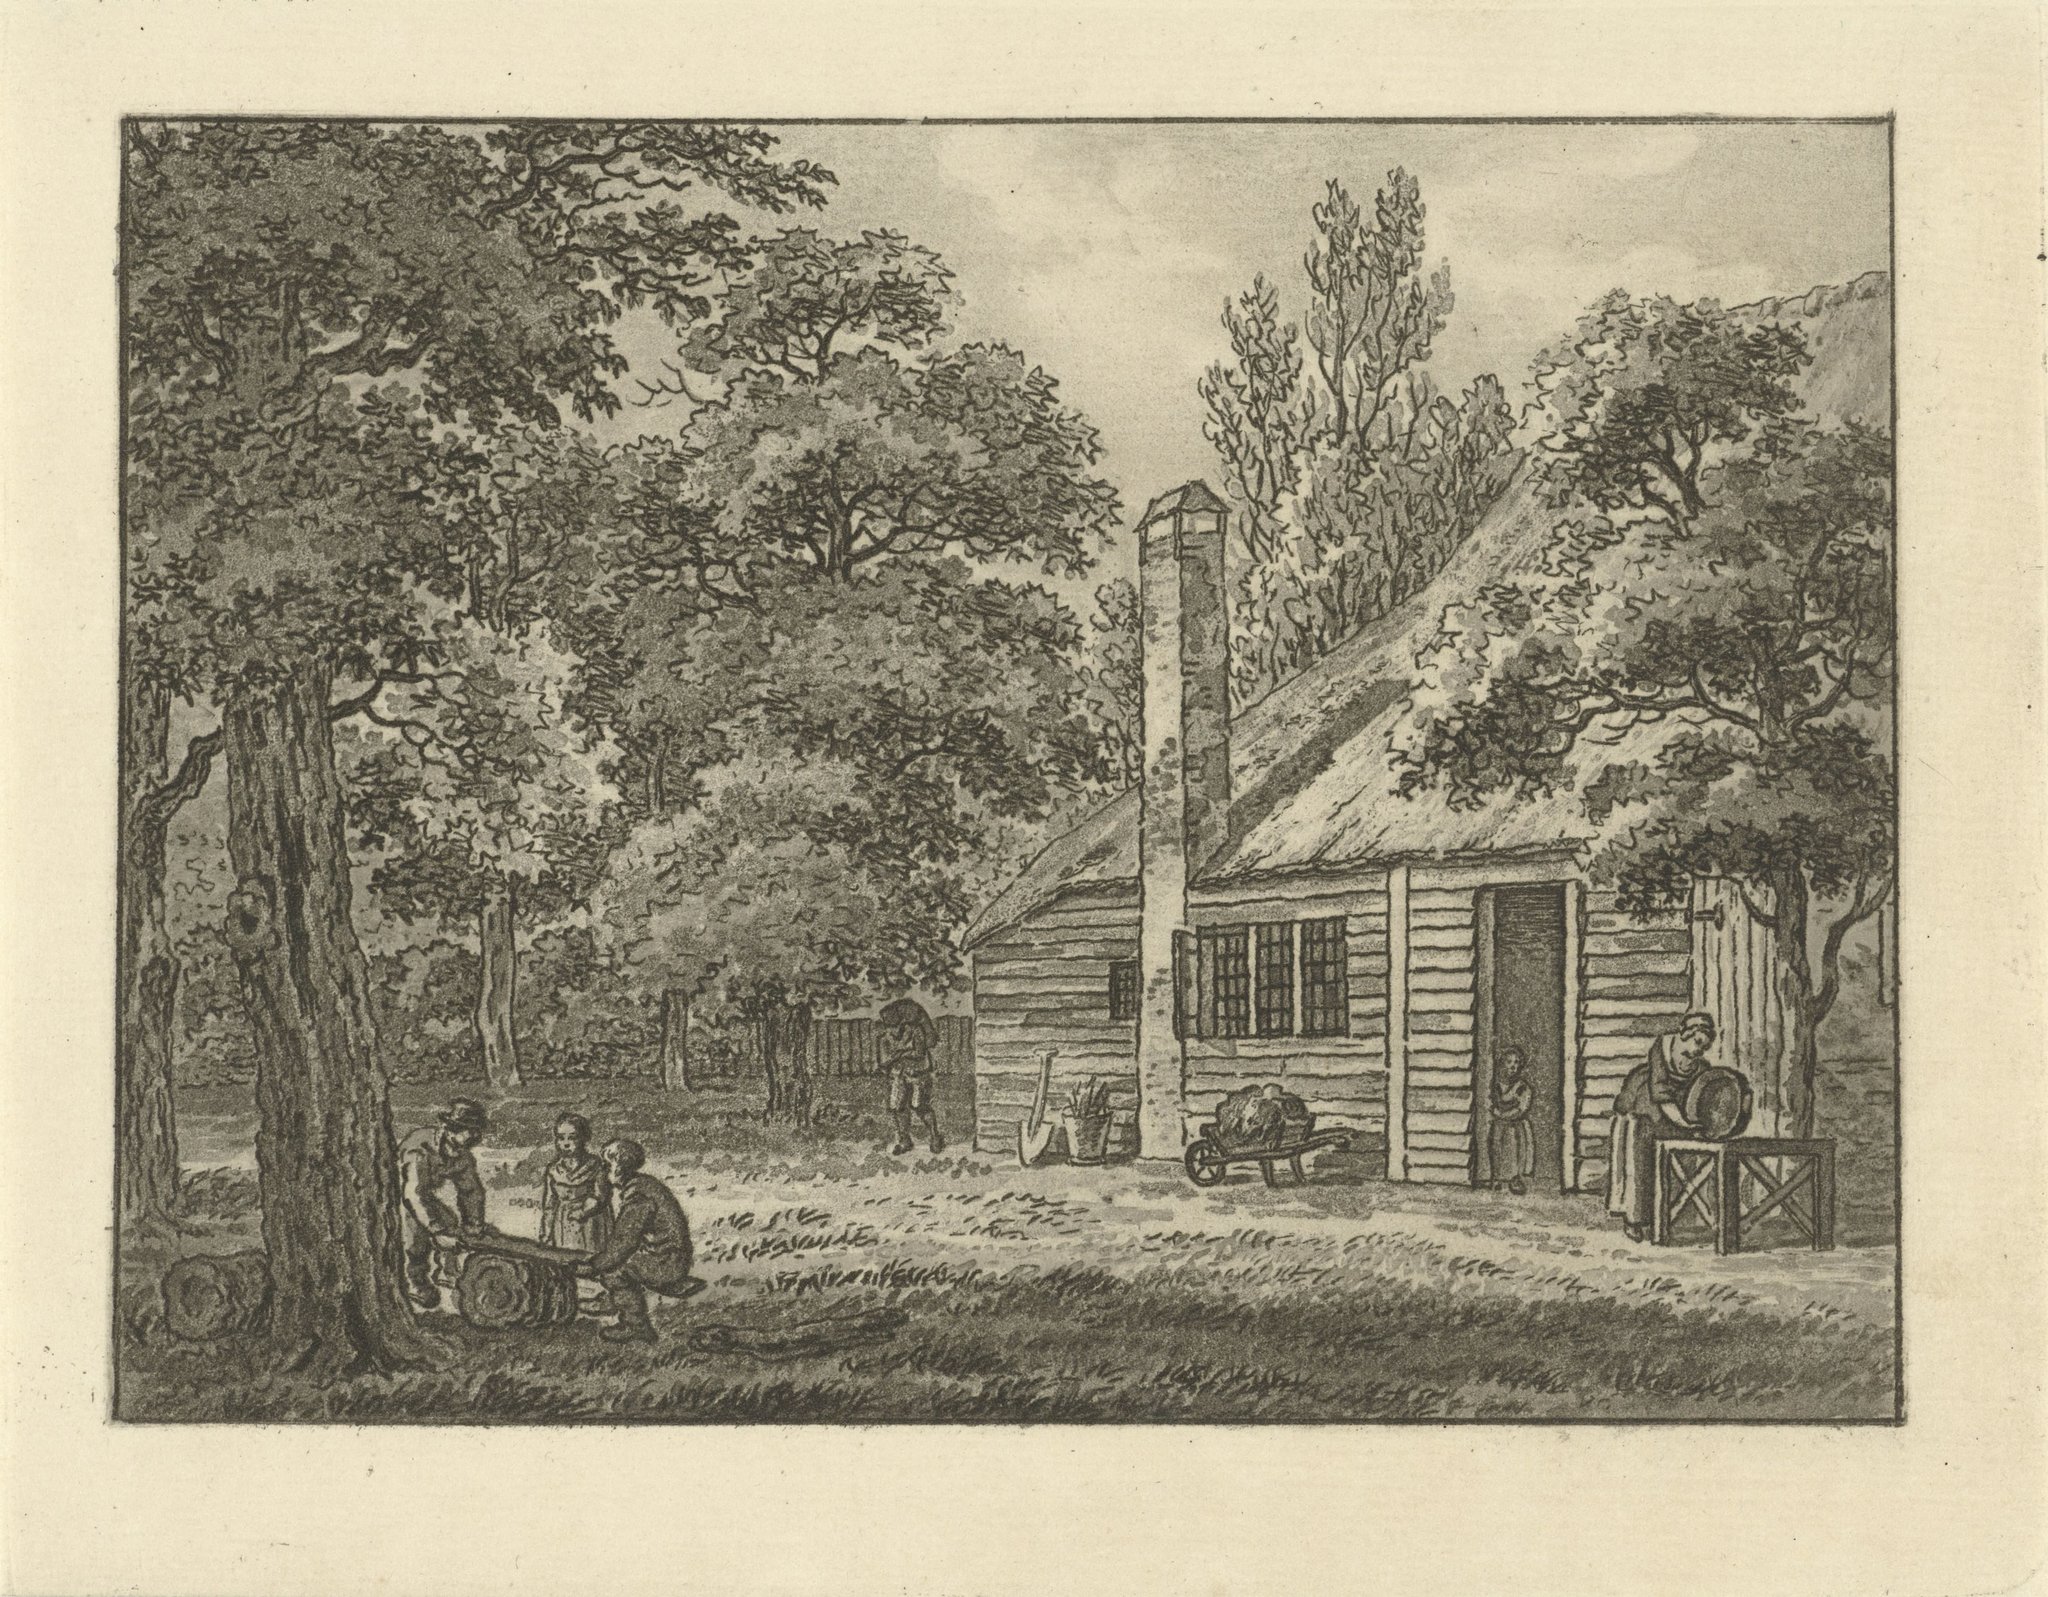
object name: print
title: Boerenerf met spelende kinderen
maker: jan evert grave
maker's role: draughtsman, print maker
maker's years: 1759-1805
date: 1769-1805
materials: paper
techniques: aquatint, etching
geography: amsterdam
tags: farm or solitary house in landscape (+ city(-scape) with figures, staffage), seesaw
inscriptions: collector's mark: Lugt 2228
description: Een boerenerf met rechts de boerderij. Links kinderen op een wip